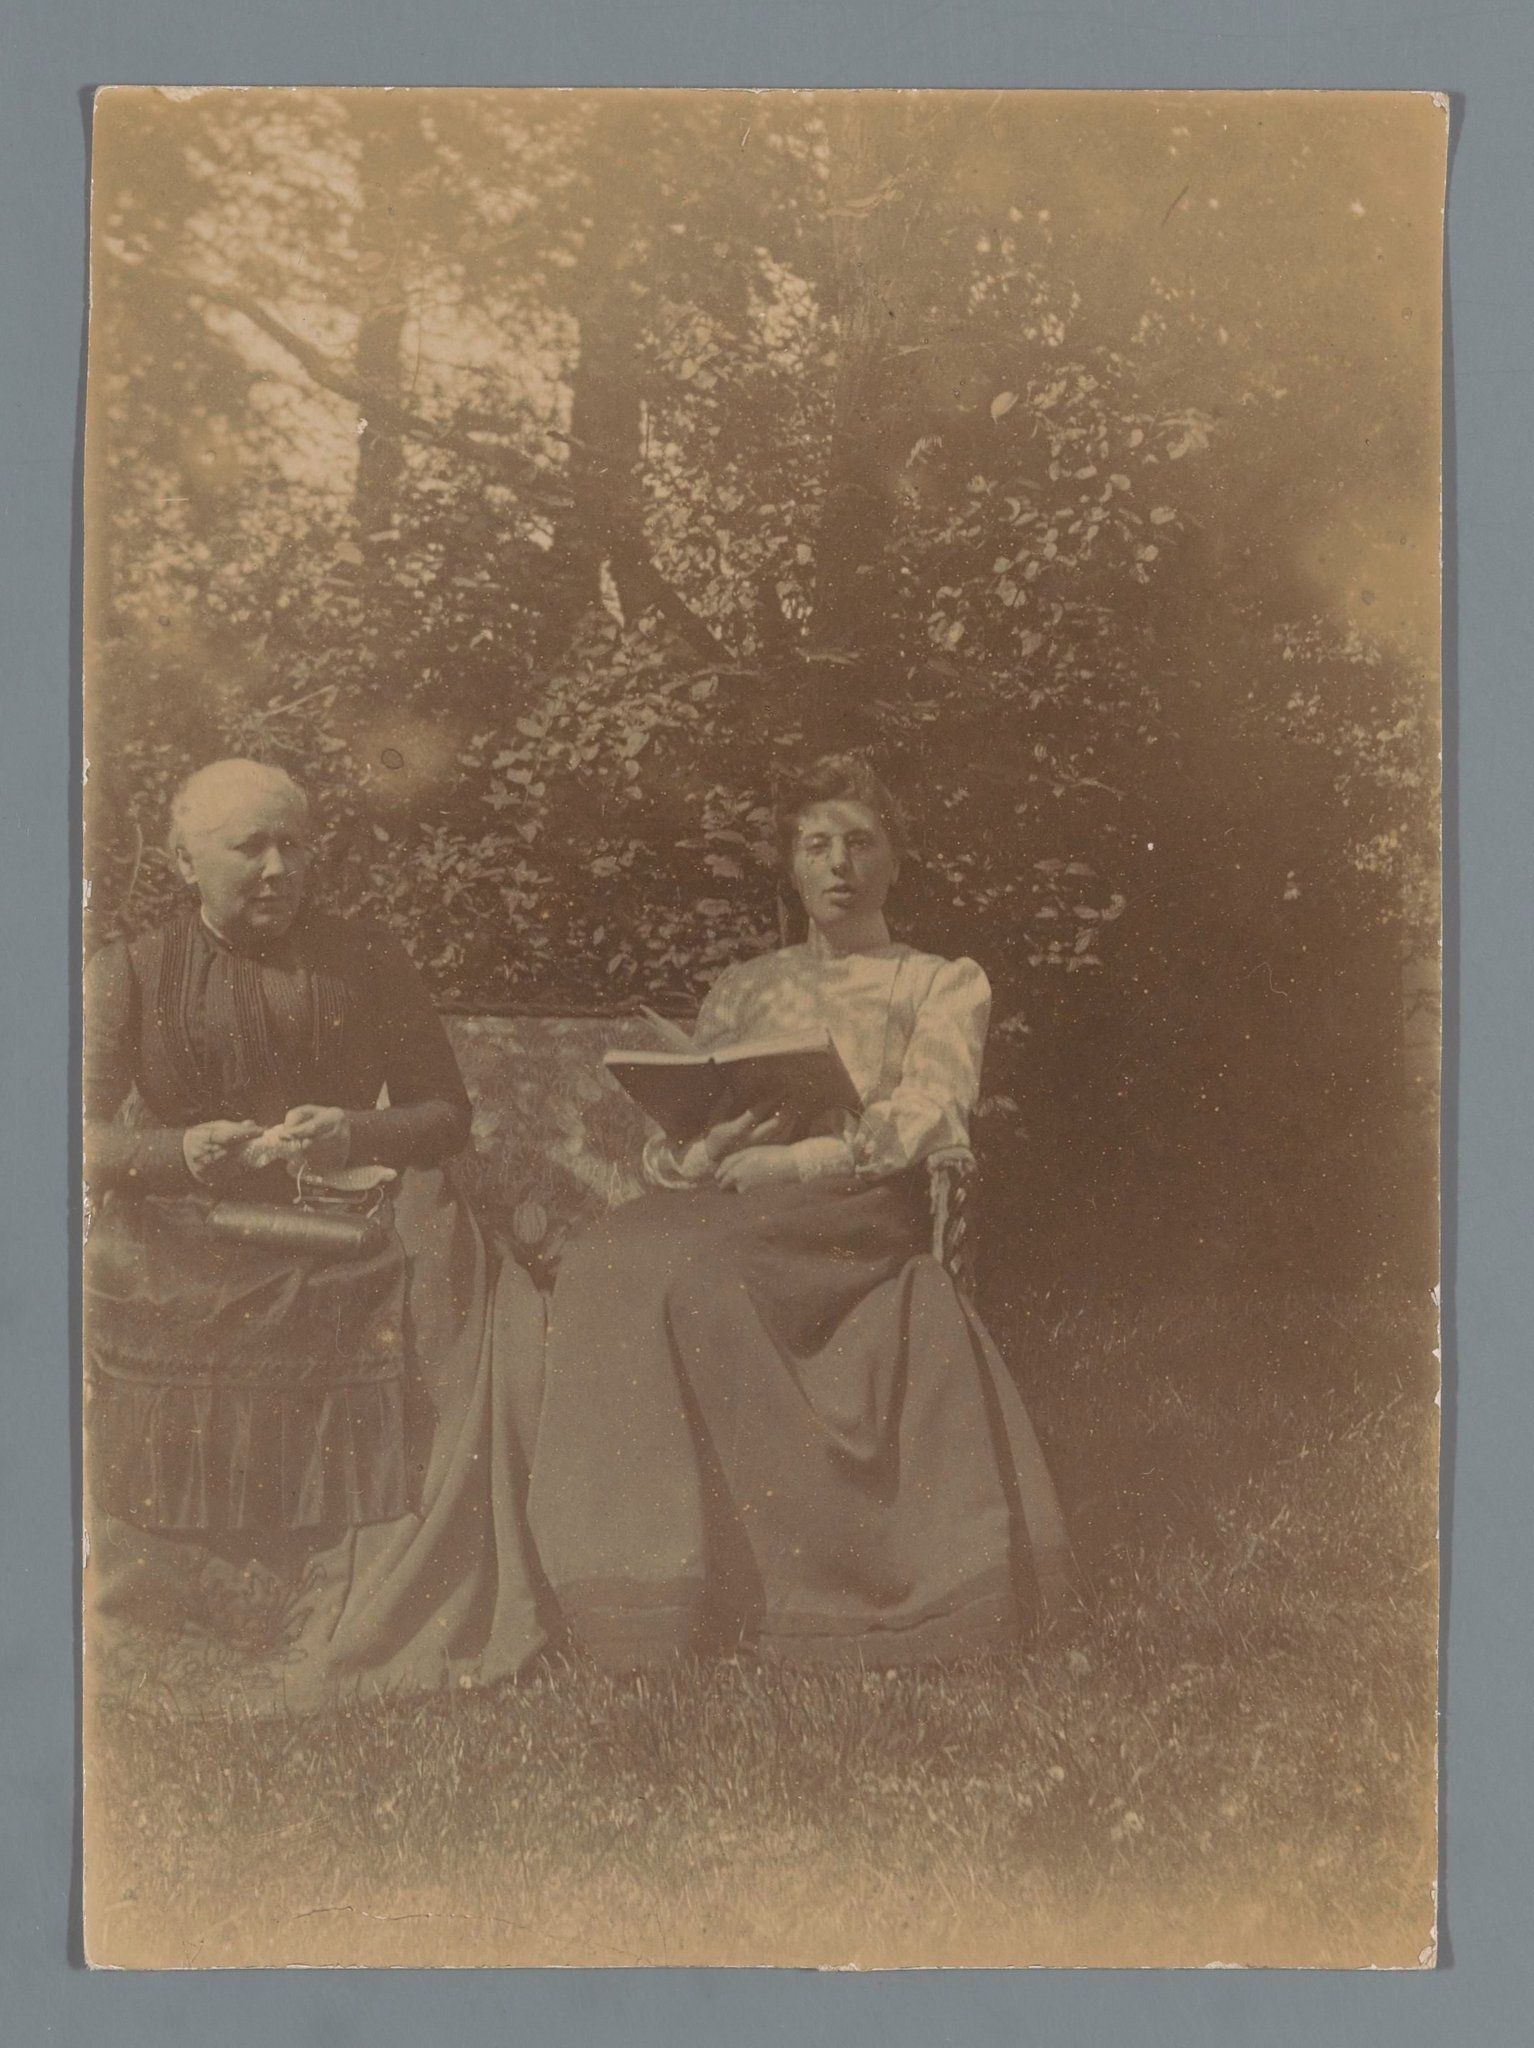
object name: photograph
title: Portret van twee vrouwen in een tuin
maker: Anonymous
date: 1900-1915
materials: photographic support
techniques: gelatin silver print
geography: netherlands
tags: adult woman, reading, garden